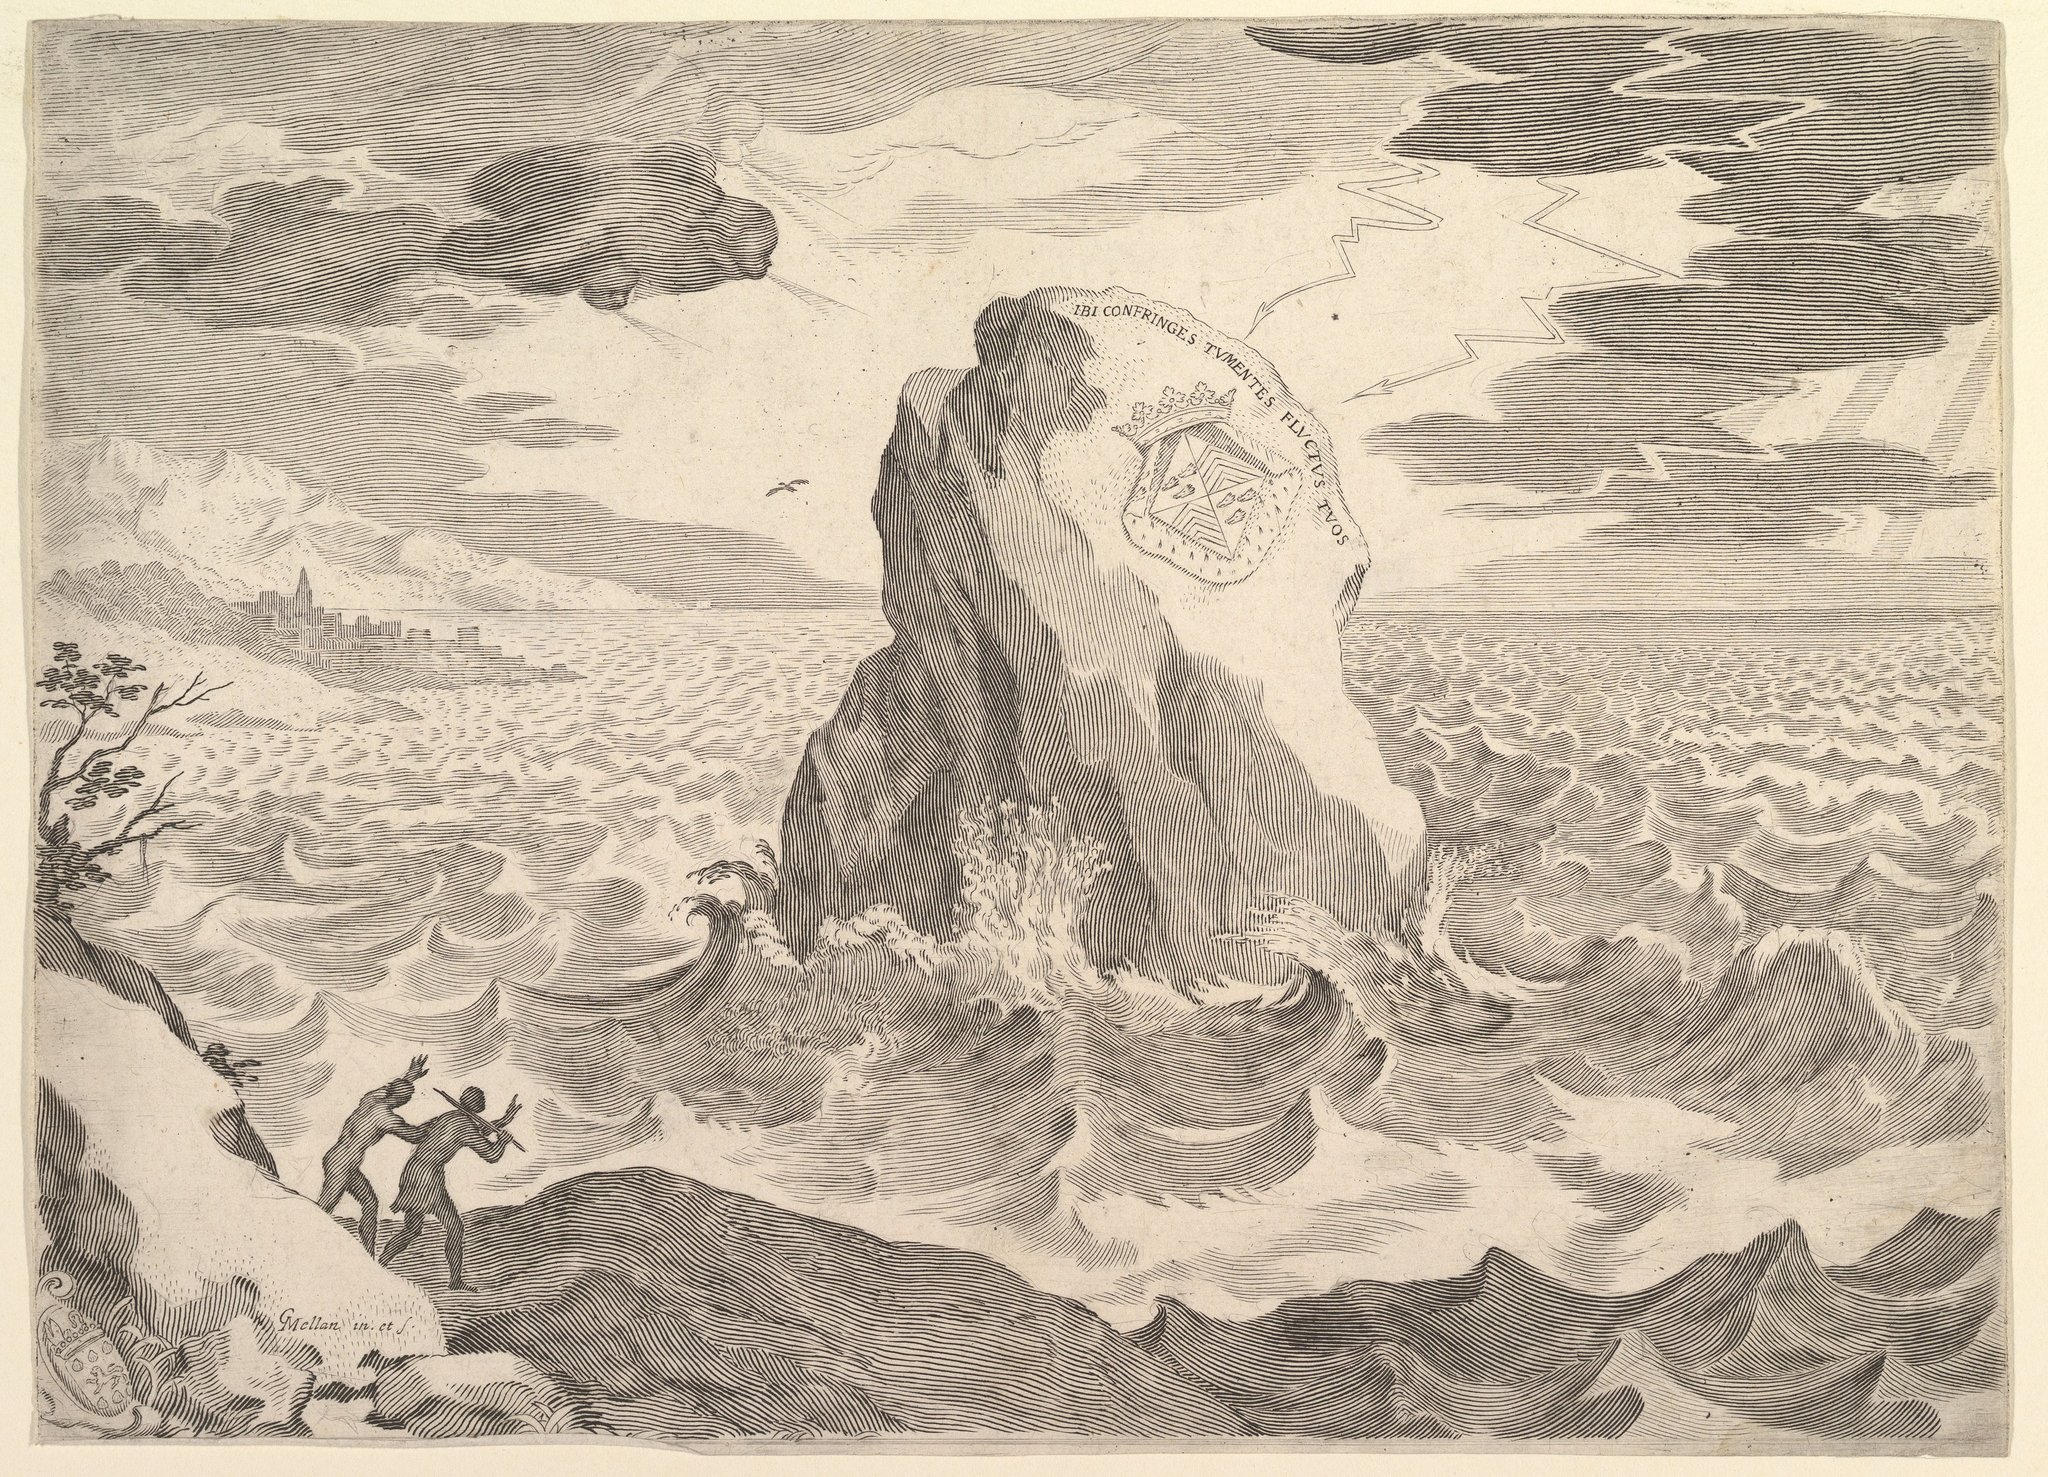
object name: print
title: Allegory Against the Pelagian Heresy (Allégorie contre l'hérésie pélagienne et armoiries de la duchesse d'Aiguillon)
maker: claude mellan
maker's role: artist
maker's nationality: french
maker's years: 1598-1688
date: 1600-1688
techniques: engraving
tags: men,coat of arms,allegory